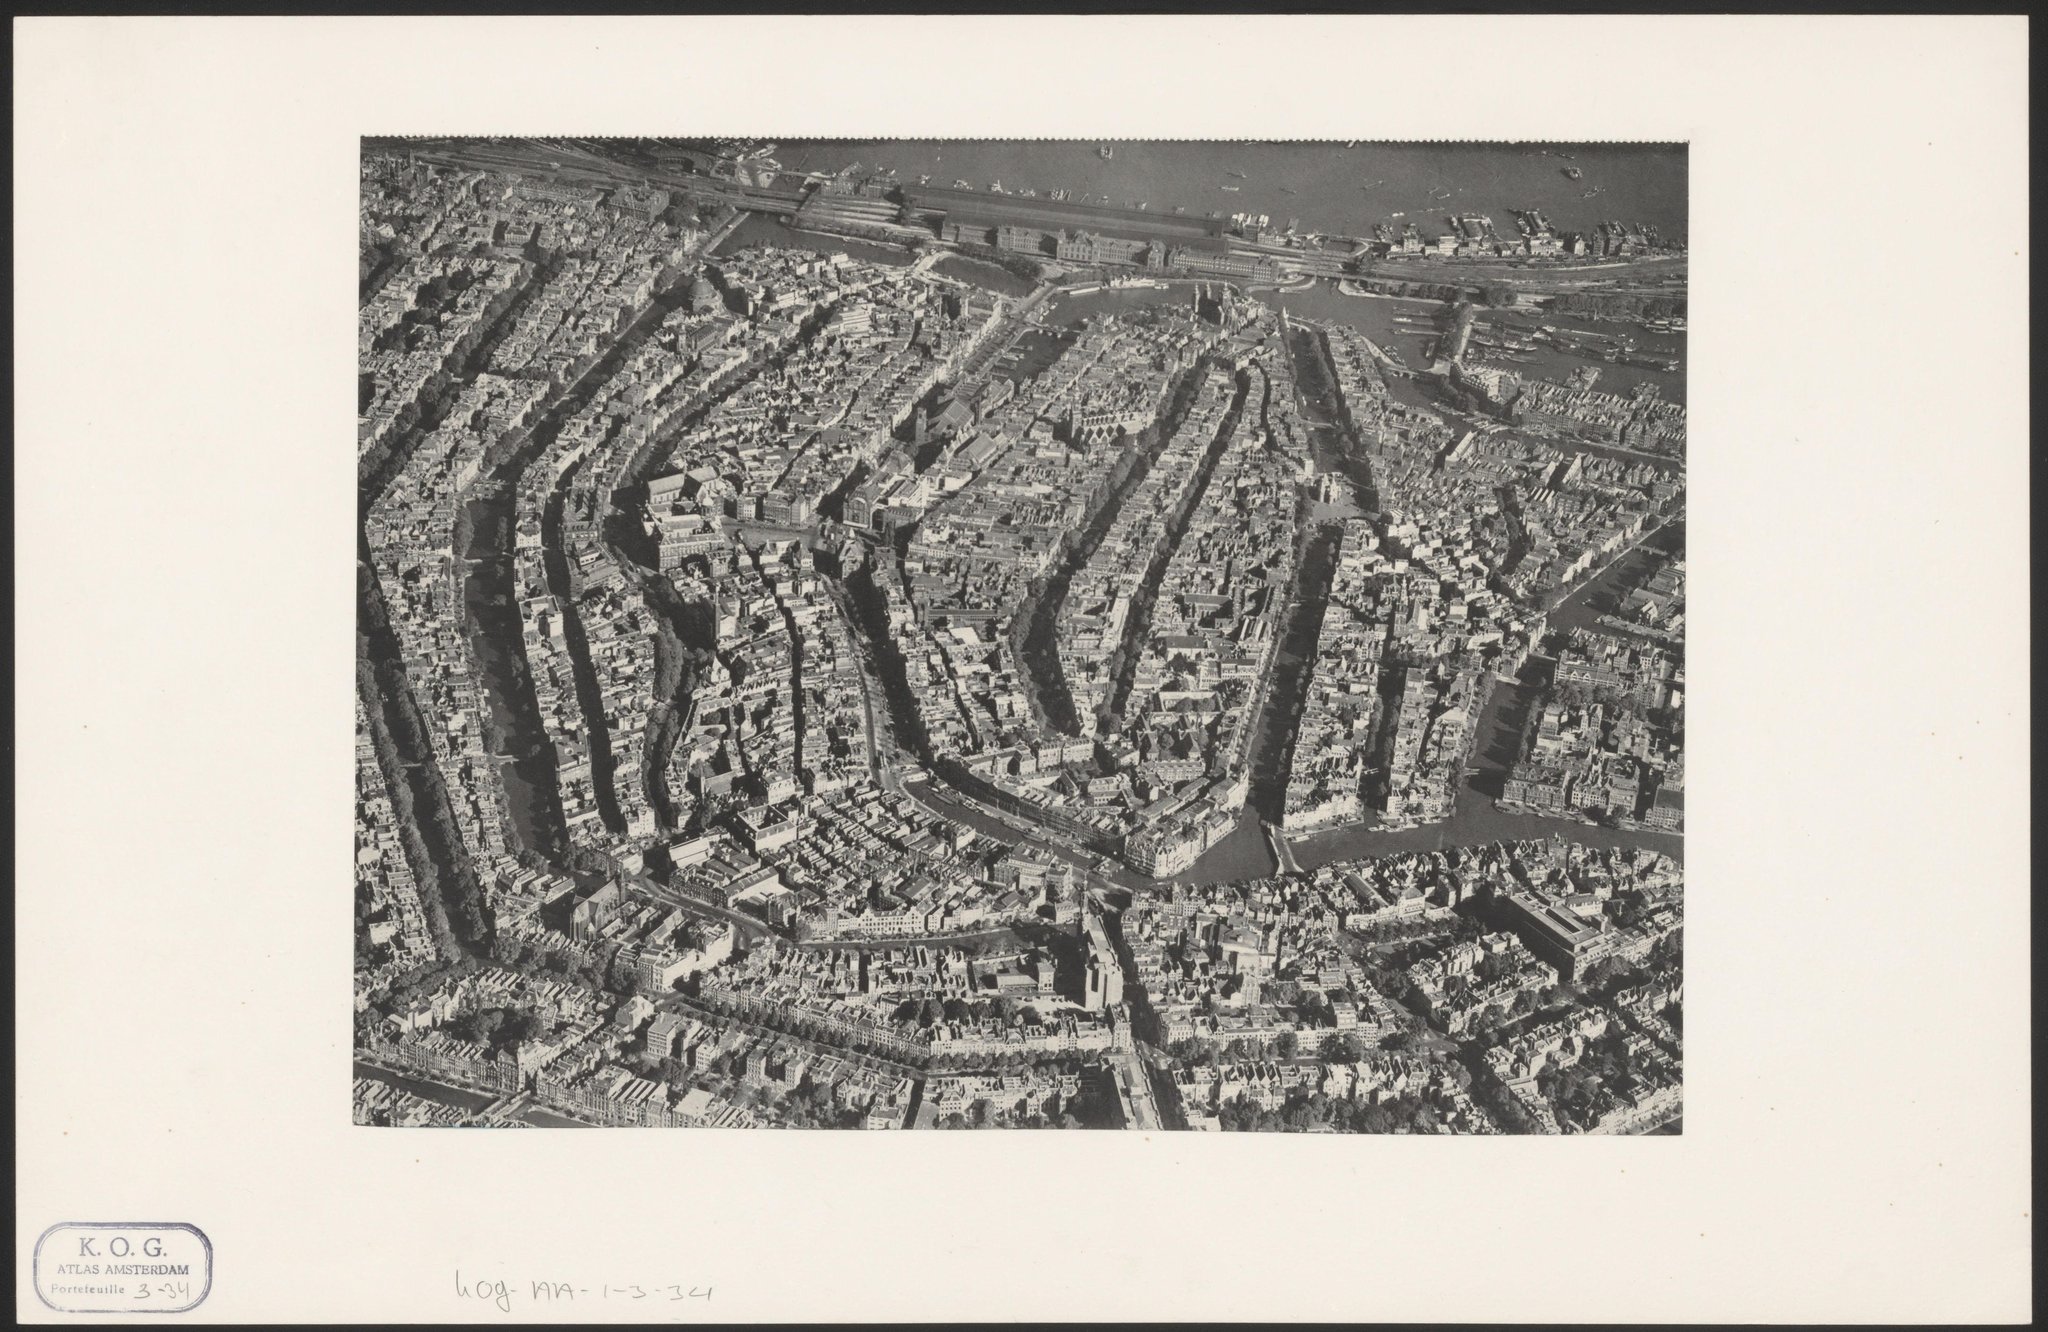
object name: photomechanical print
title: Panorama van de stad Amsterdam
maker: Anonymous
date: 1903-1950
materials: paper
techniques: autotype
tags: prospect of city, town panorama, silhouette of city, amsterdam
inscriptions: collector's mark: ‘3-34’ Lugt 1641b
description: Onderwerpsrubriek binnen de Atlas Amsterdam: Panorama's en verzamelprenten.